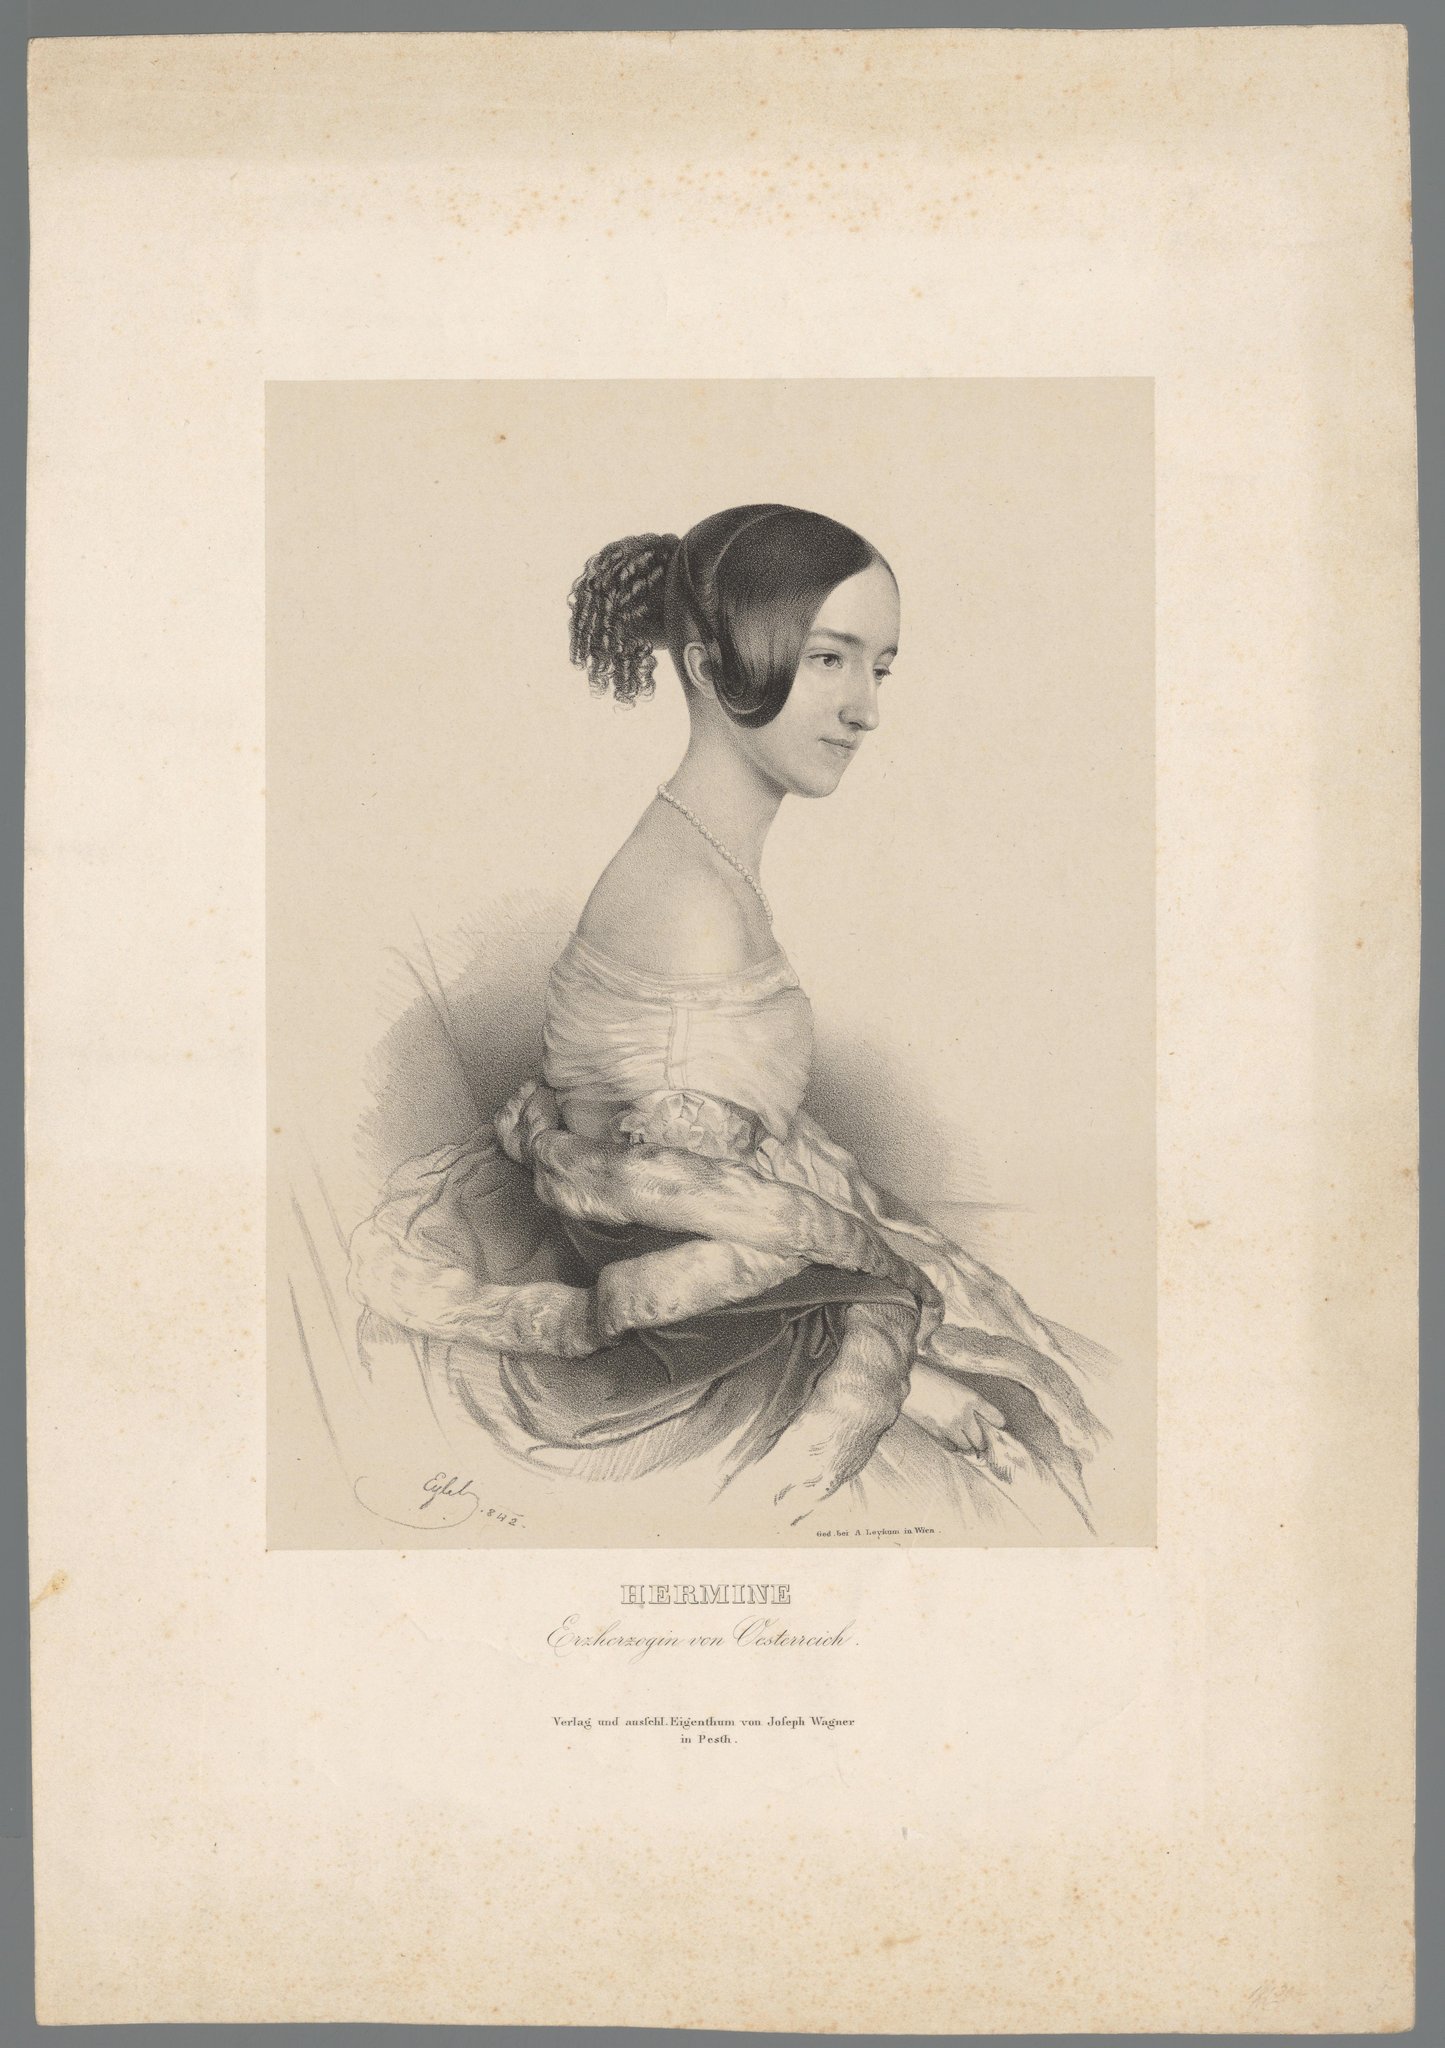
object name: print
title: Portret van Hermine Amalie Marie van Oostenrijk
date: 1842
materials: paper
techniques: lithograph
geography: vienna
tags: historical persons, abbot - pp - abbess, princess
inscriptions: collector's mark: Lugt 2228